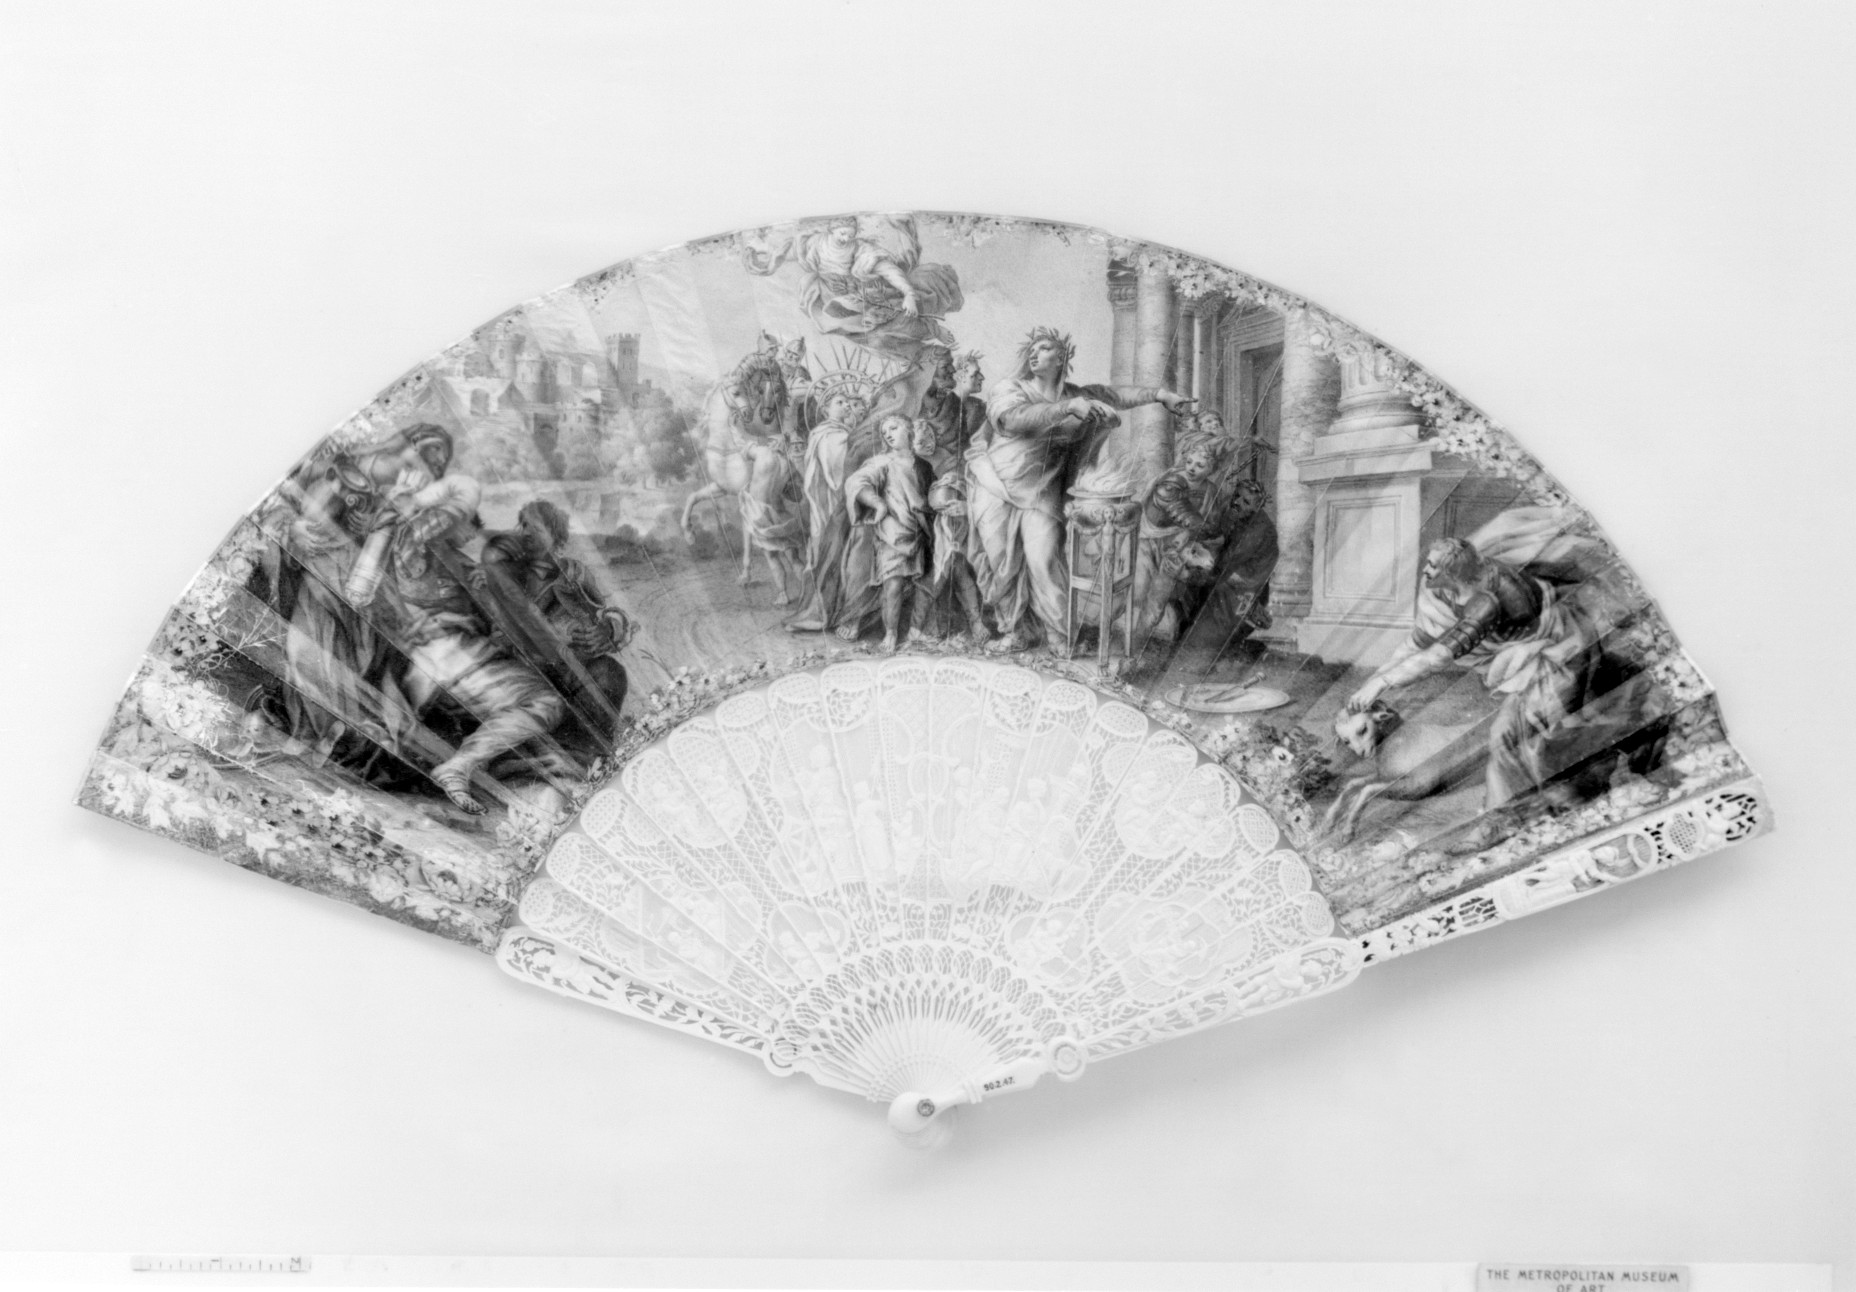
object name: fan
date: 1701-1800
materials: ivory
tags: animals,men,women